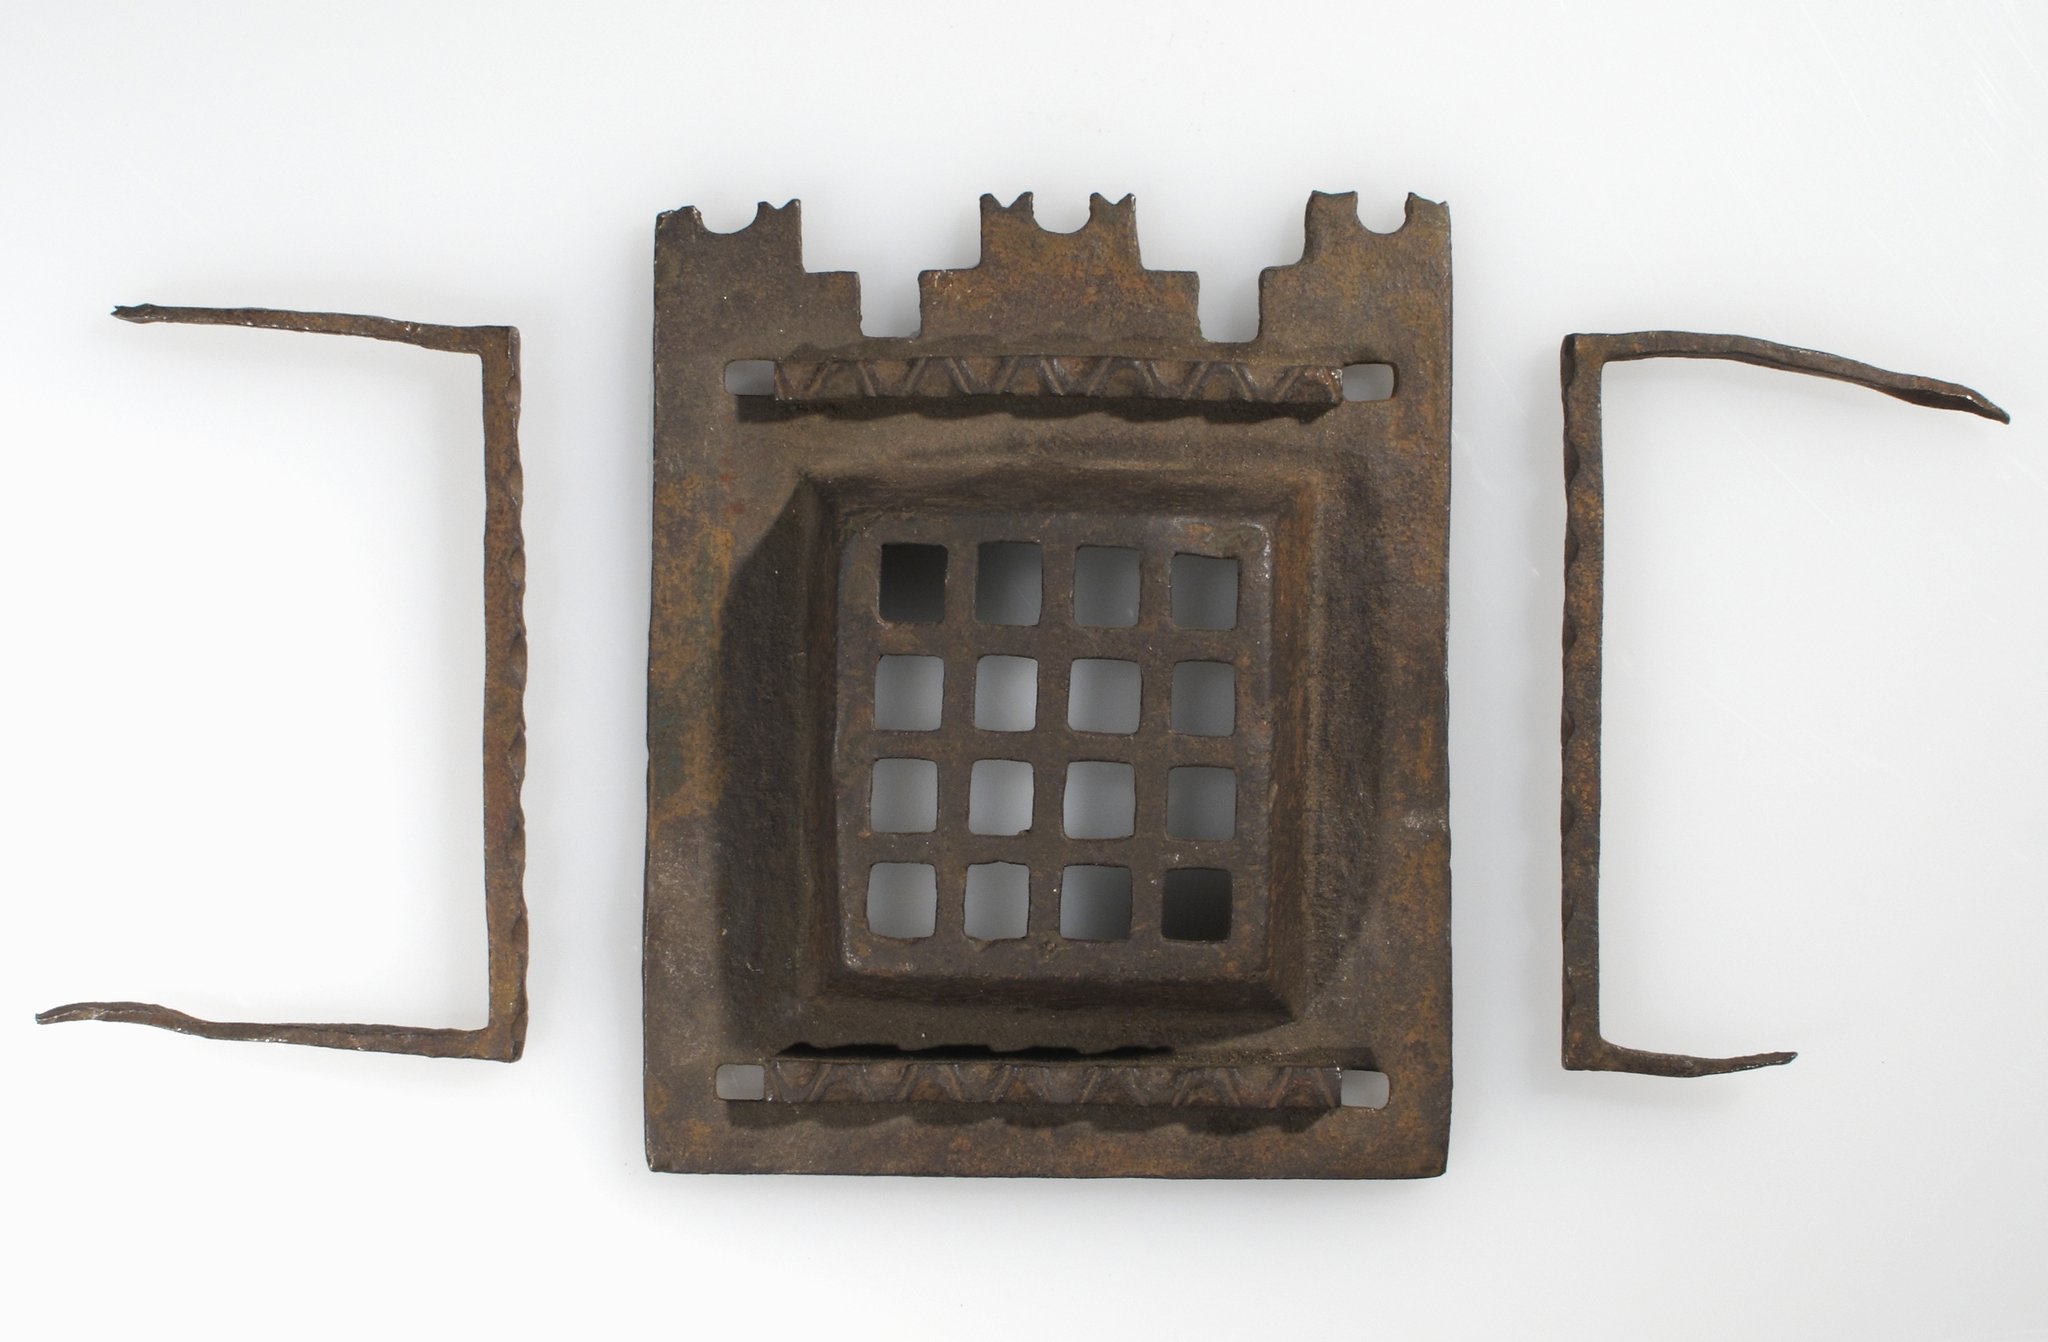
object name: grill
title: Grille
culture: european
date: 1401-1600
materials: iron